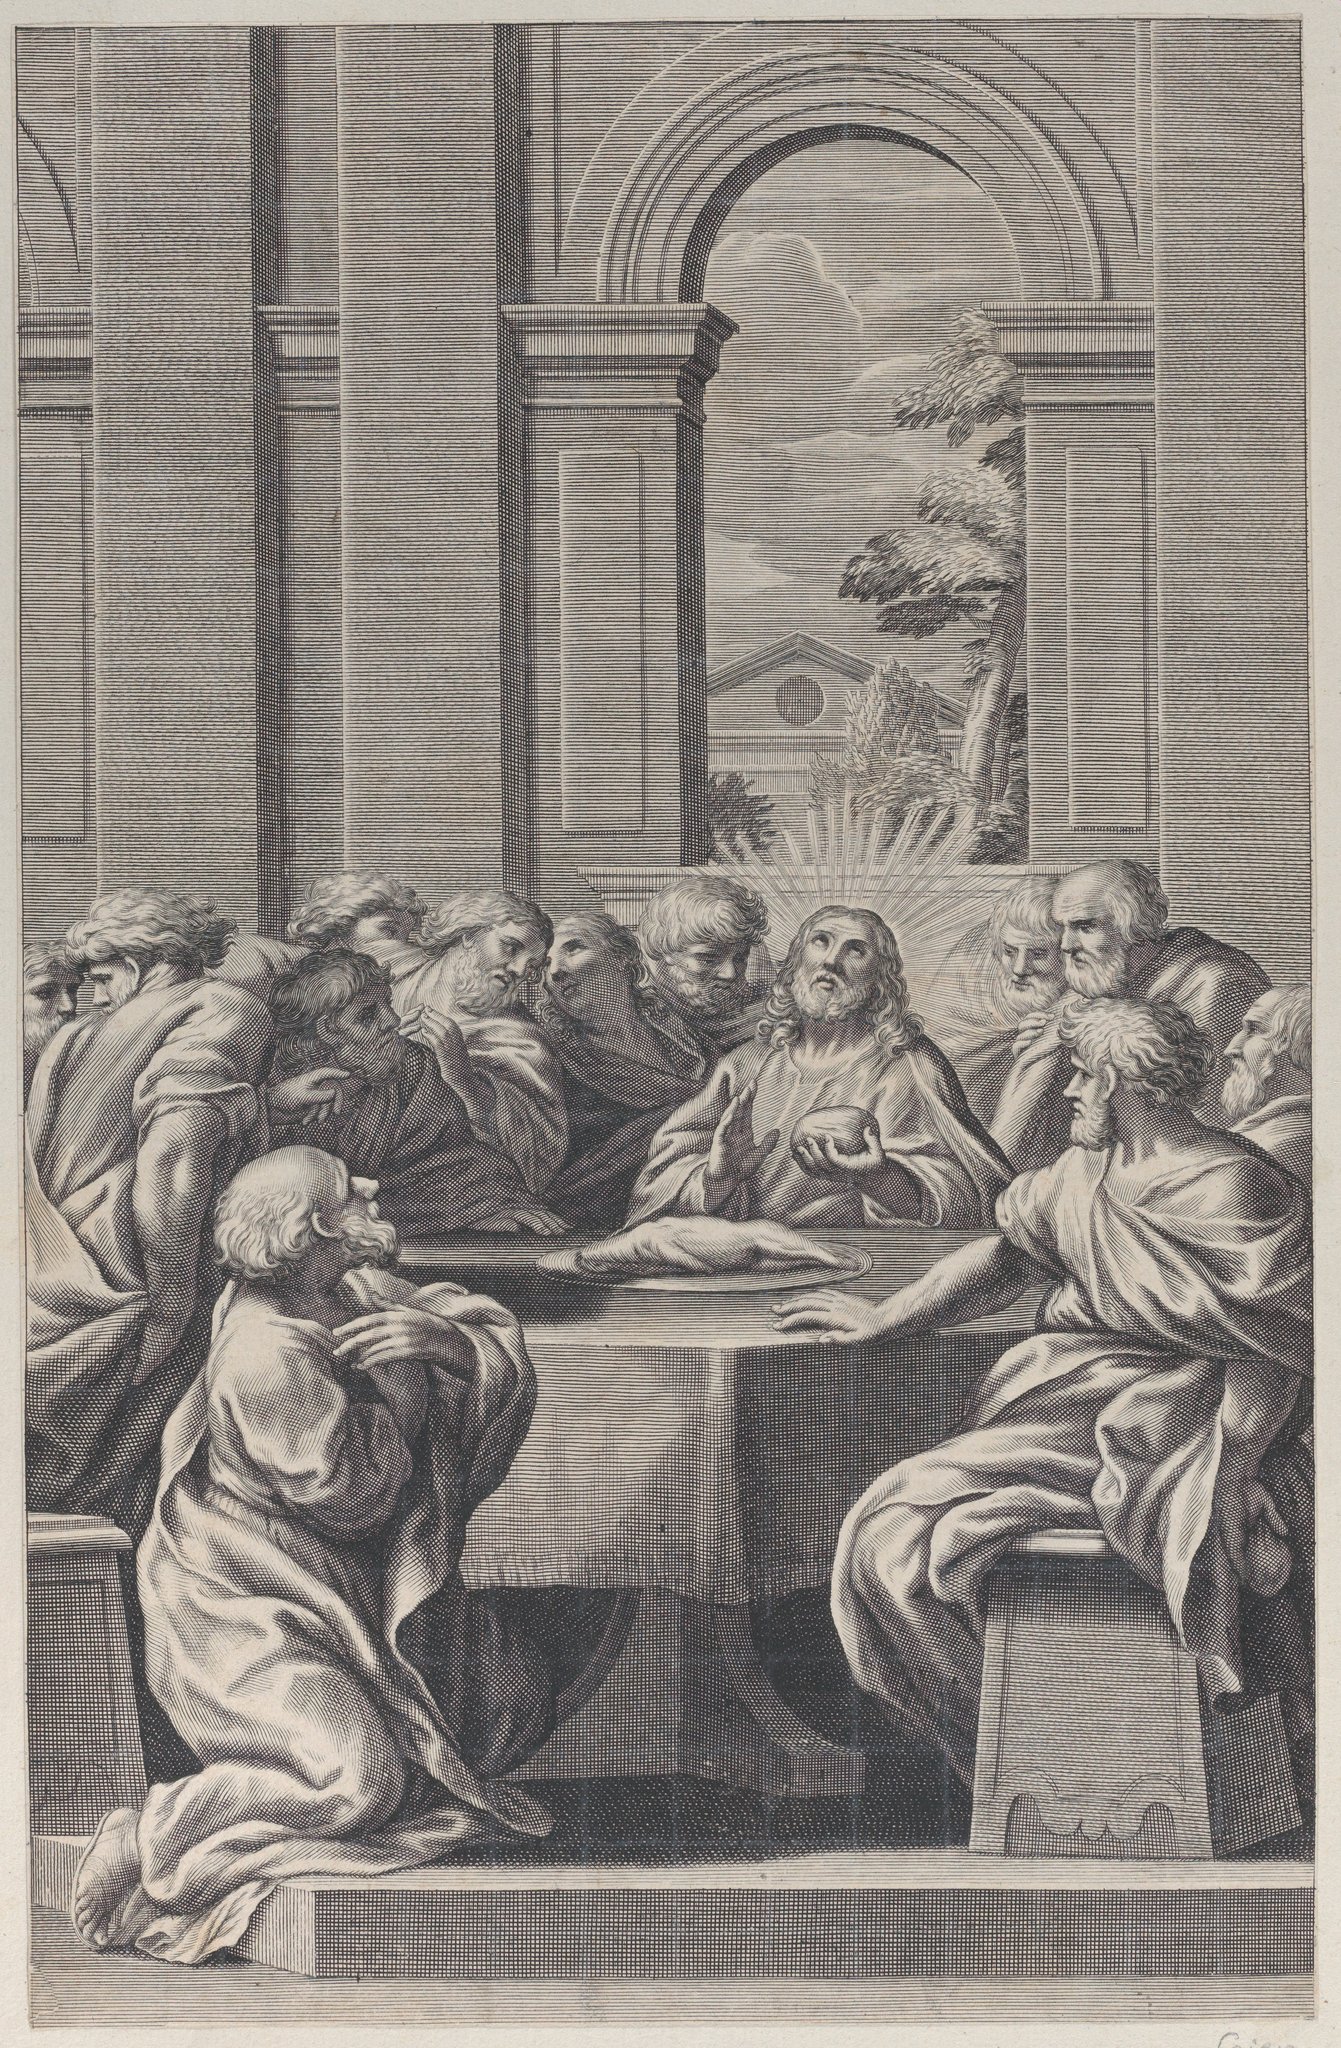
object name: print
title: The Last Supper, the interior of a classical building with Christ and his apostles seated at a table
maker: françois spierre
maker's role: artist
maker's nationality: french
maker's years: 1639-1681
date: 1660-1681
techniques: engraving